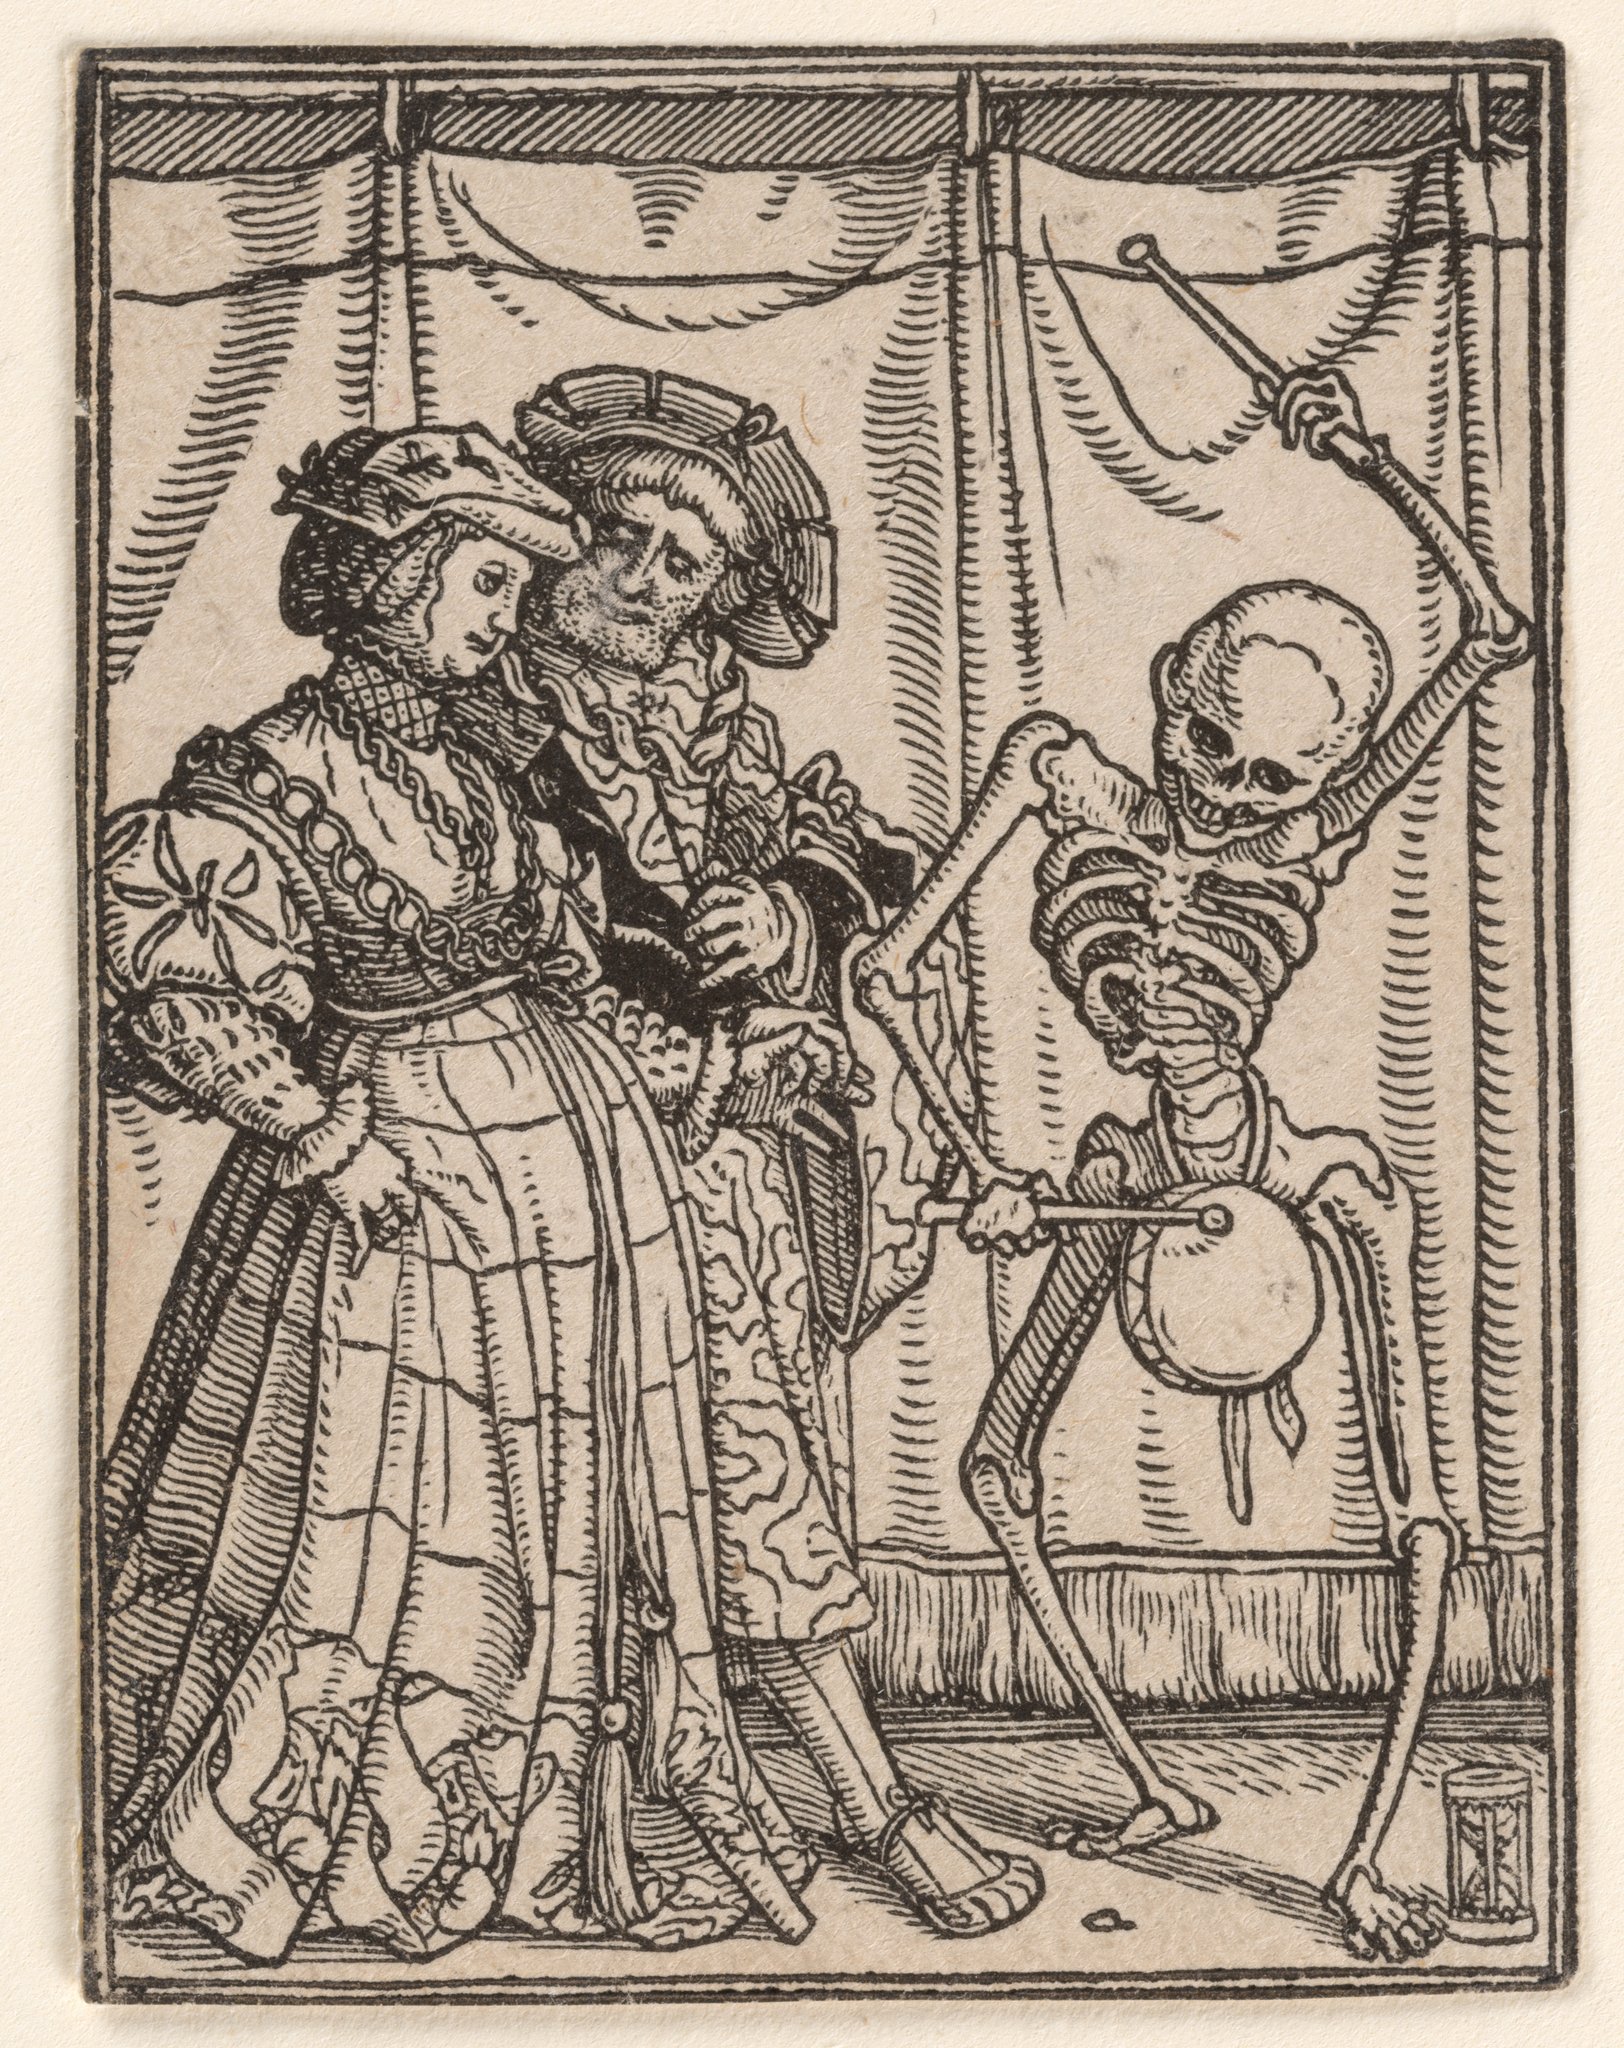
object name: print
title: The Noblewoman, from "The Dance of Death"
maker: hans holbein the younger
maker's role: artist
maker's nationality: german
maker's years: 1497-1543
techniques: woodcut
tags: skeletons,men,women